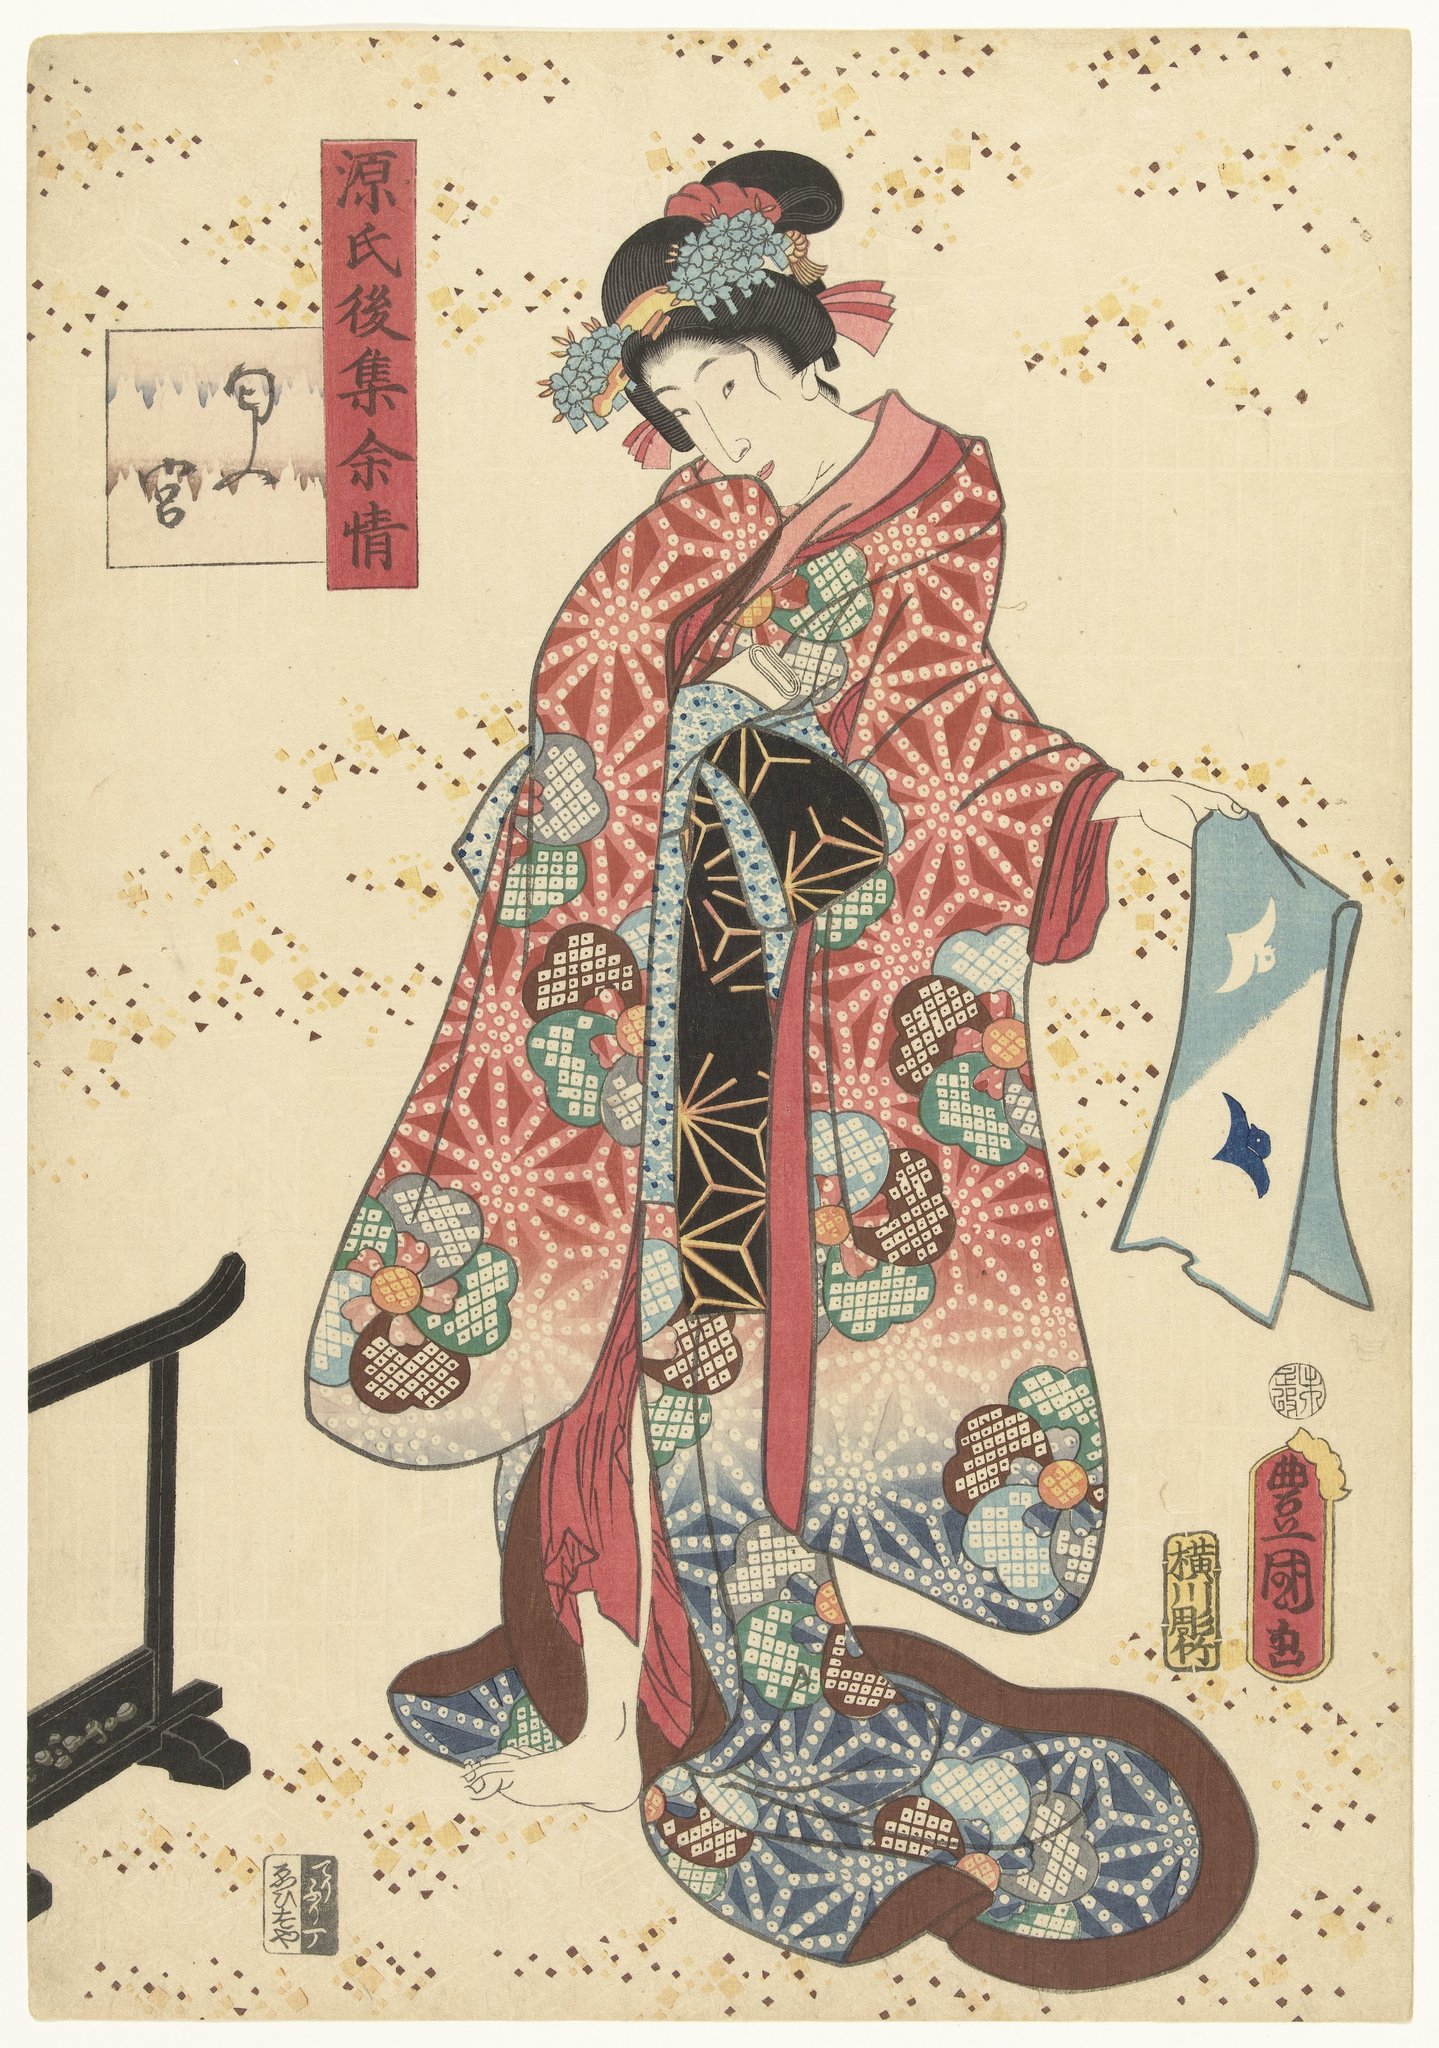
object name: print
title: Prins Genji verfrist zich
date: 1801-1859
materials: paper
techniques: woodcut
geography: tokyo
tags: adult woman, towel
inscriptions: date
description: Vrouw, staand, op blote voeten, in linker hand een blauw-witte handdoek waarop gestileerd vogelmotief.